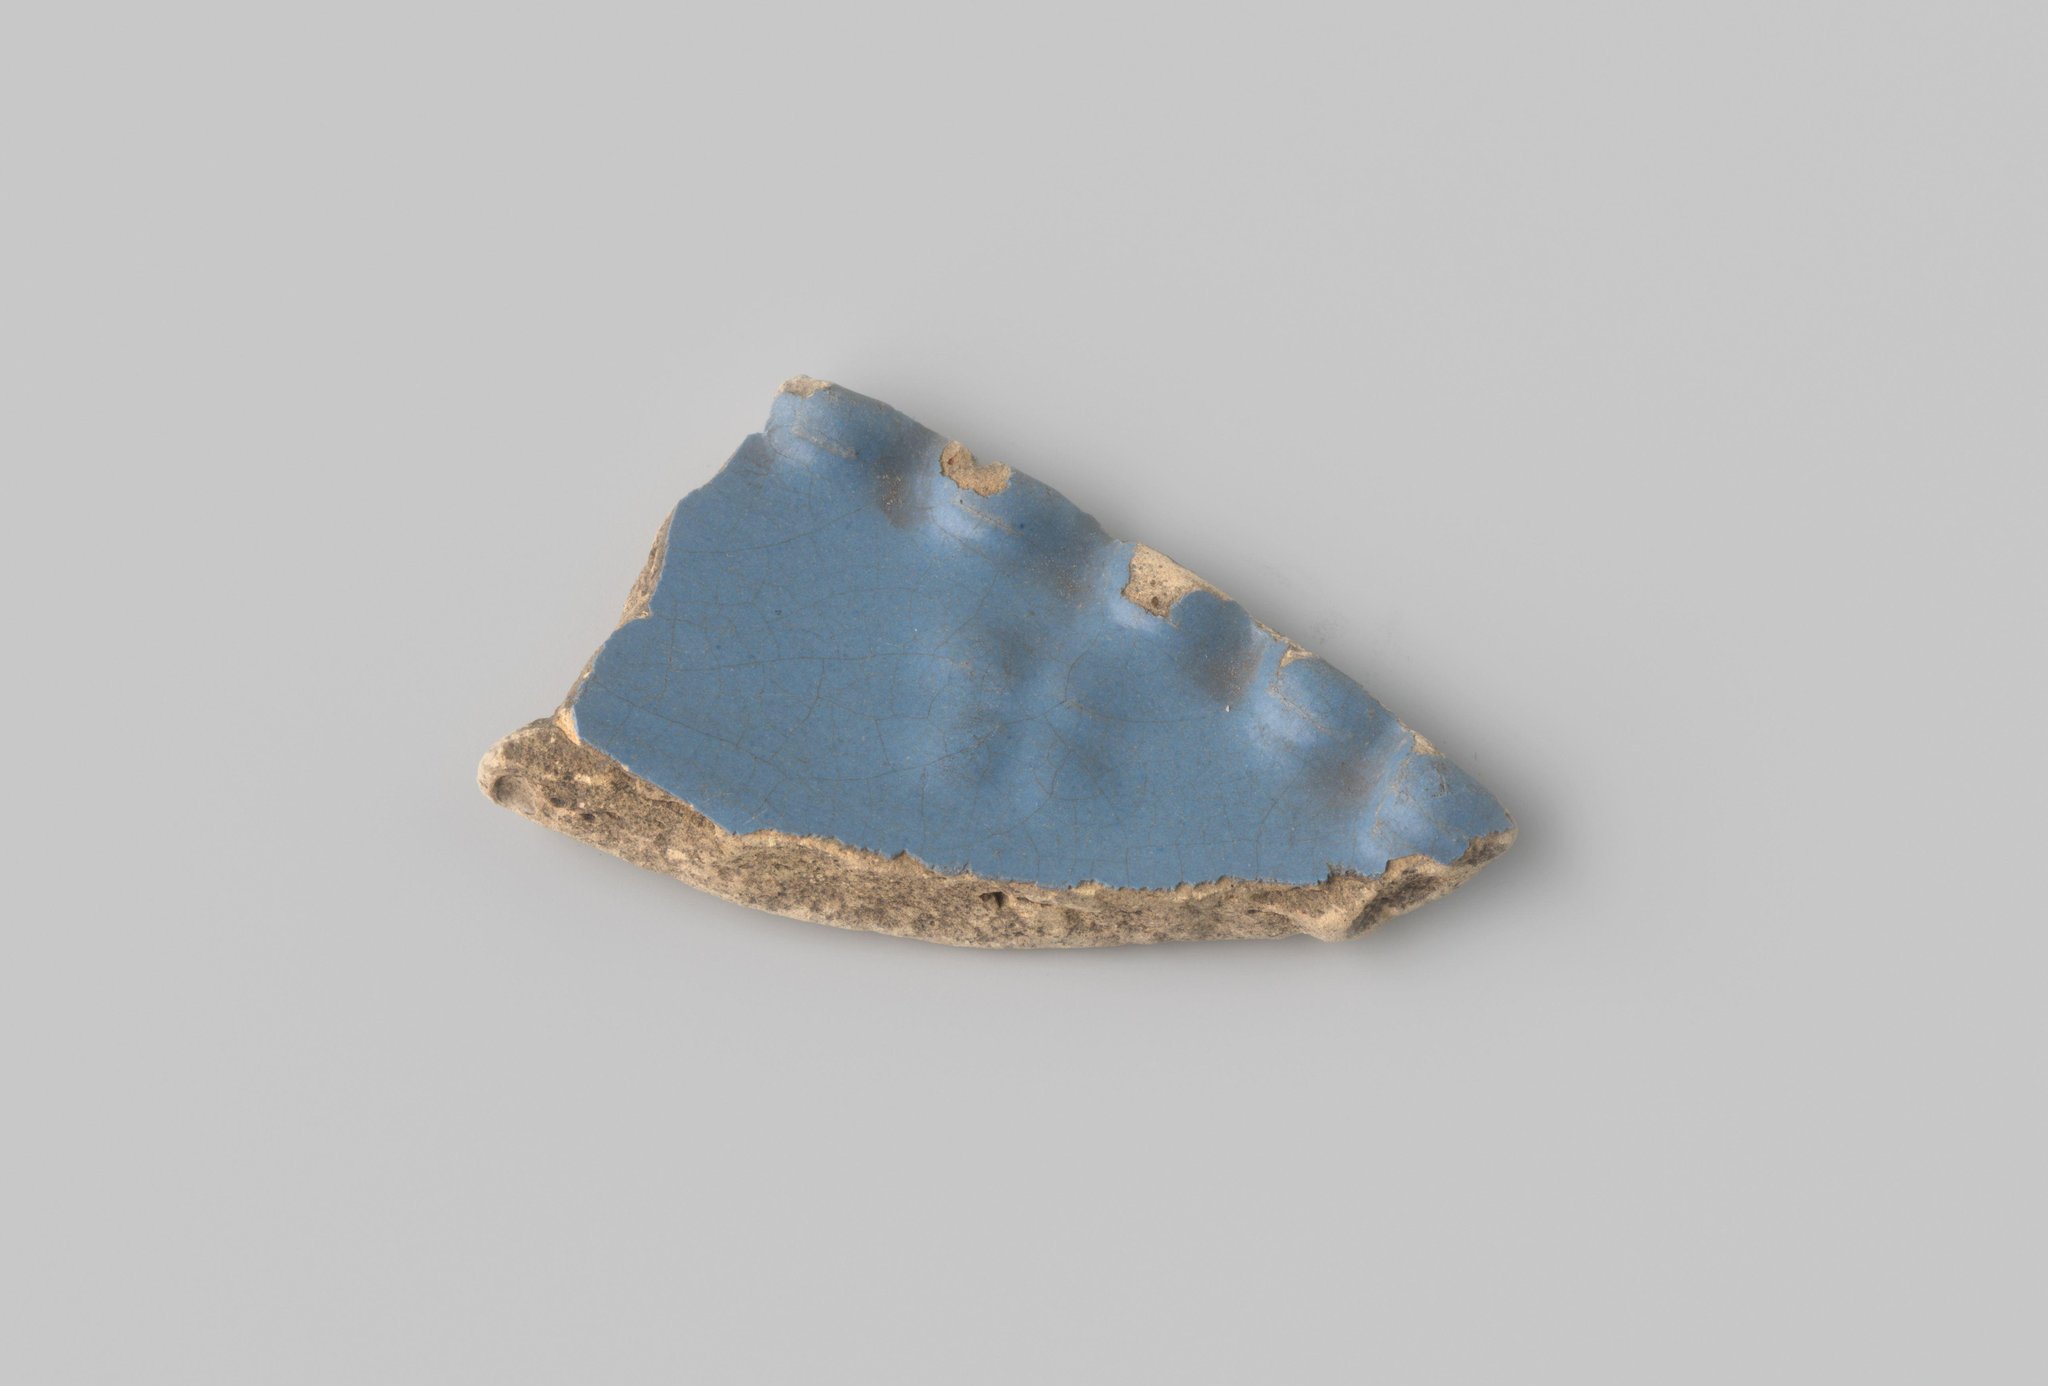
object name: sherd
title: Scherf blauw majolica met gegolfde rand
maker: Anonymous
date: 1500-1699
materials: earthenware, glaze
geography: northern netherlands